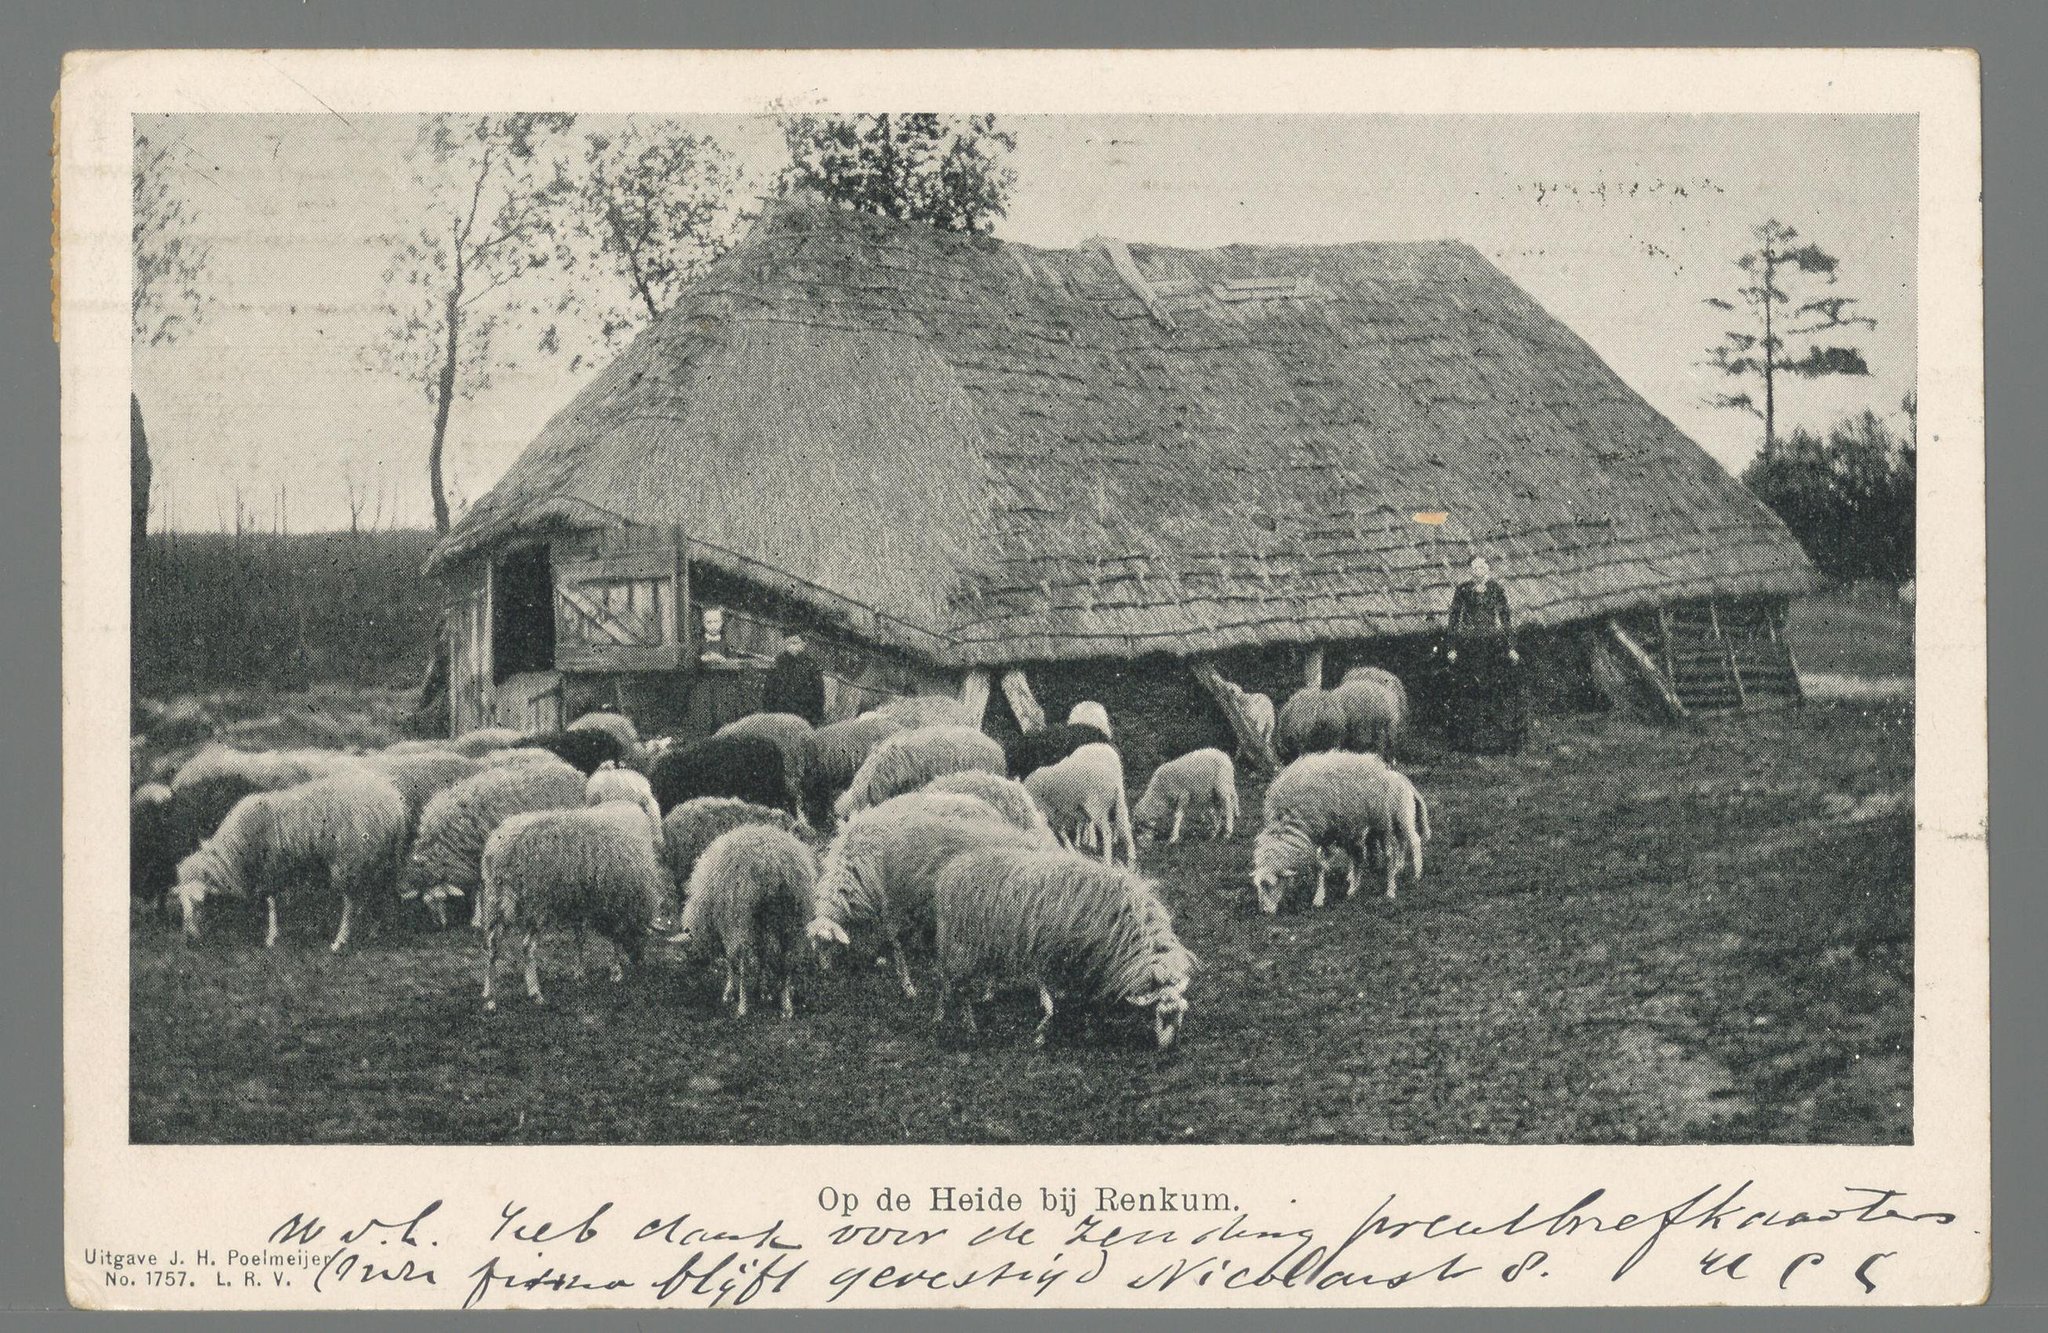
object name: ansichtkaart, prentbriefkaart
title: Op de heide bij Renkum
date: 1892-1905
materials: cardboard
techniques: writing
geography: renkum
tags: sheep, farm (building)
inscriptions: stamp: ‘Dr. H. C. Los. 's-Gravenhage’, postage stamp